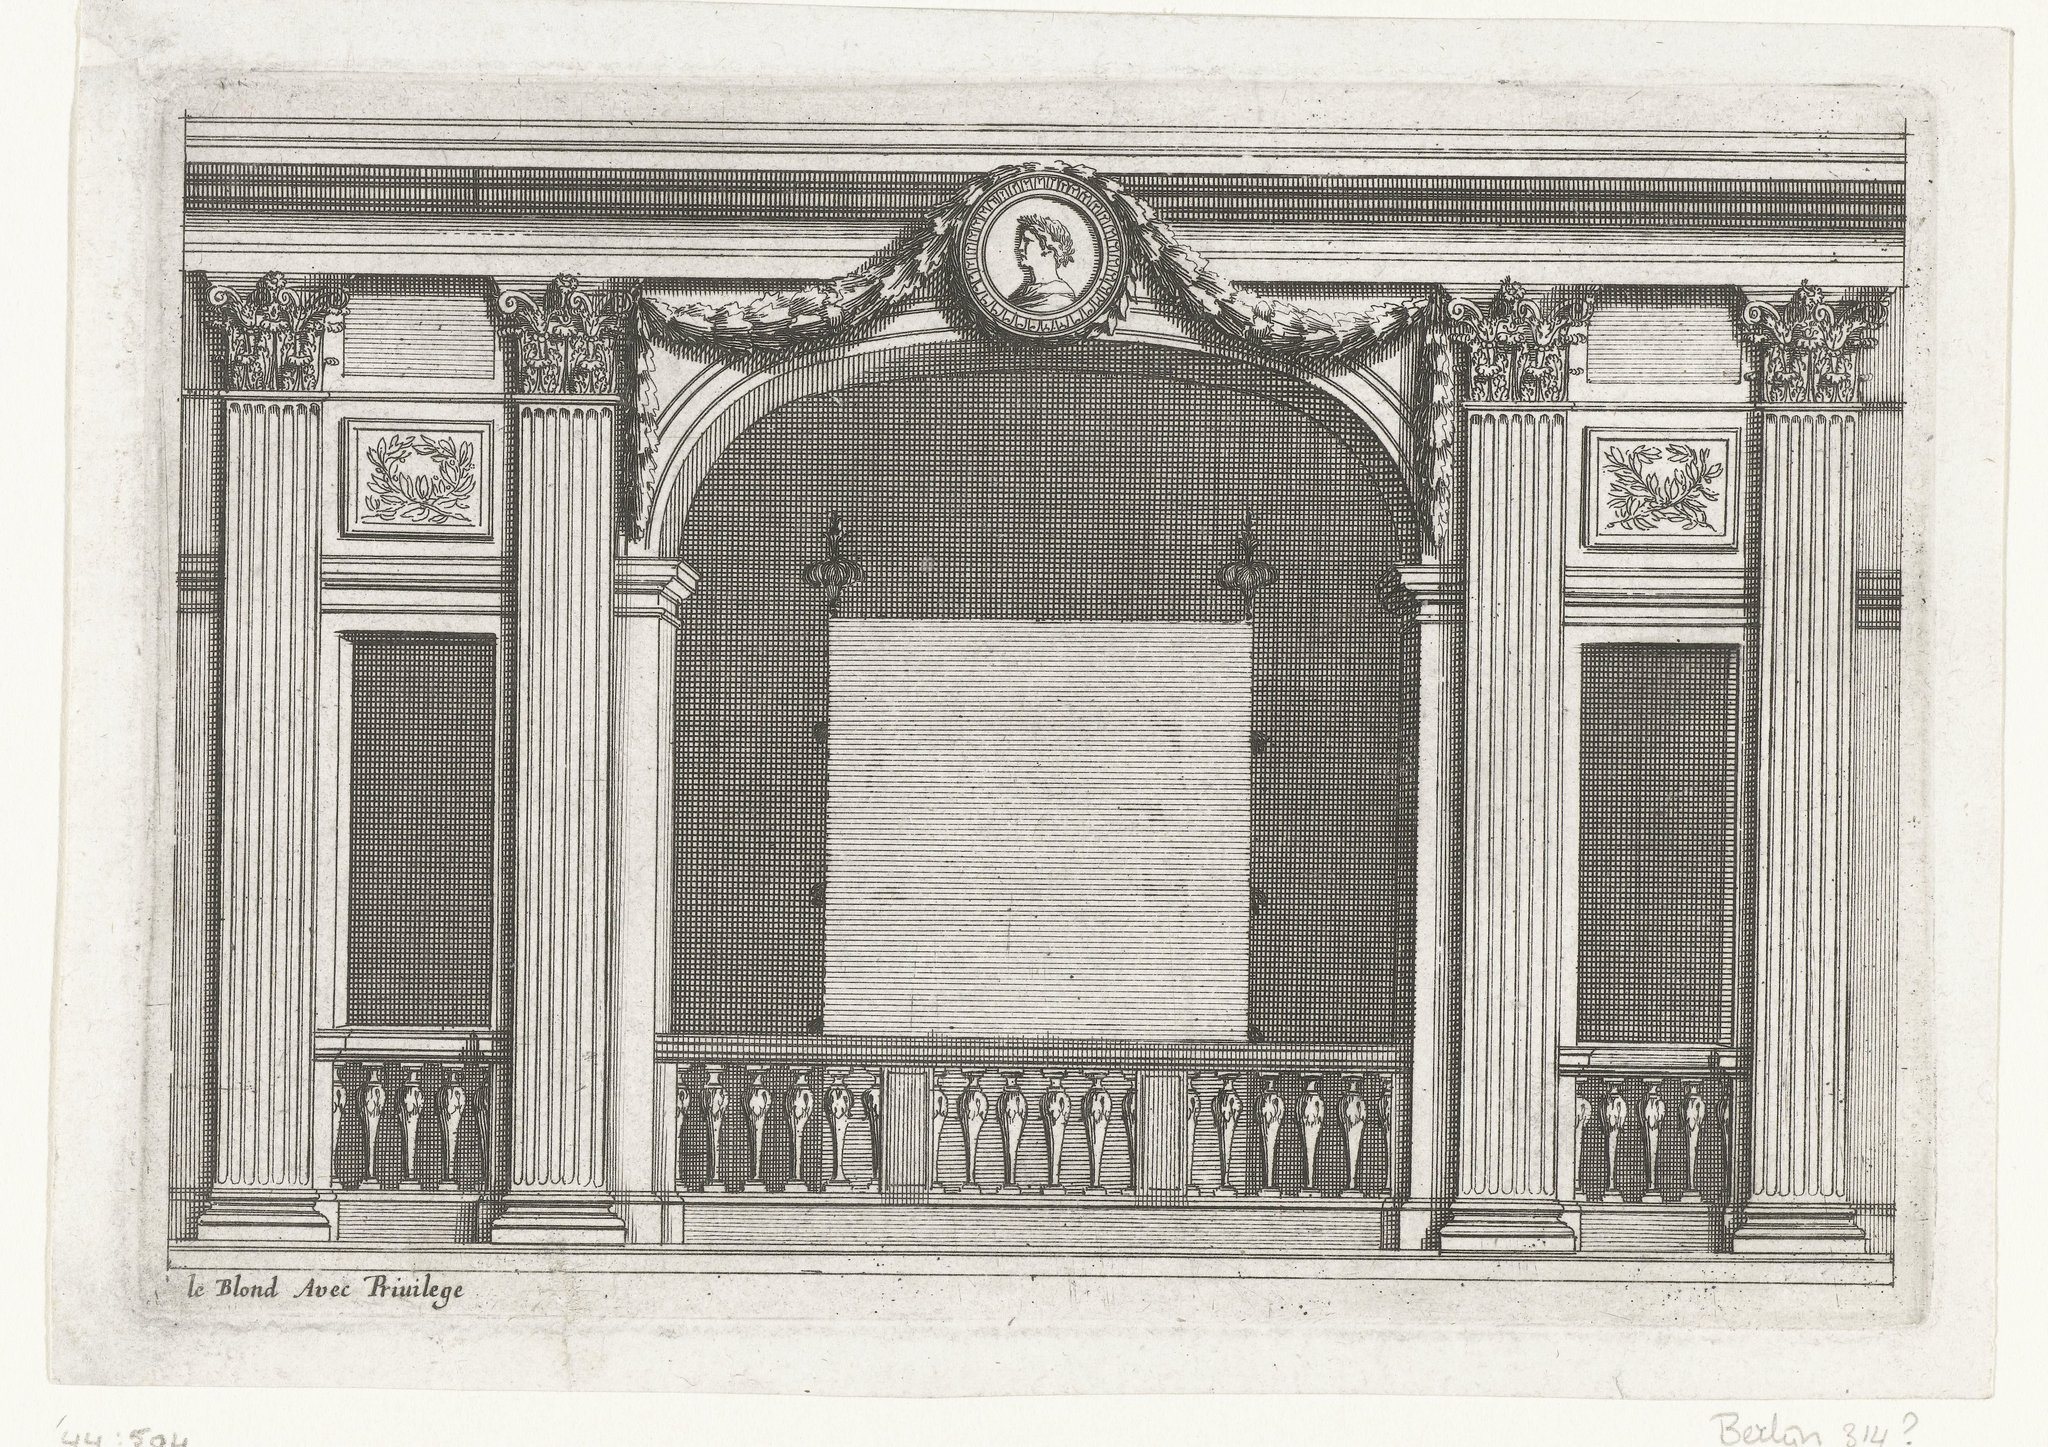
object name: print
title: Alkoven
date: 1650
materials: paper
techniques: etching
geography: france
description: Midden boven hangt een rond medaillon met een portretbuste, aan weerskanten staan twee Korintische pilasters.bUit serie van 6 bladen.